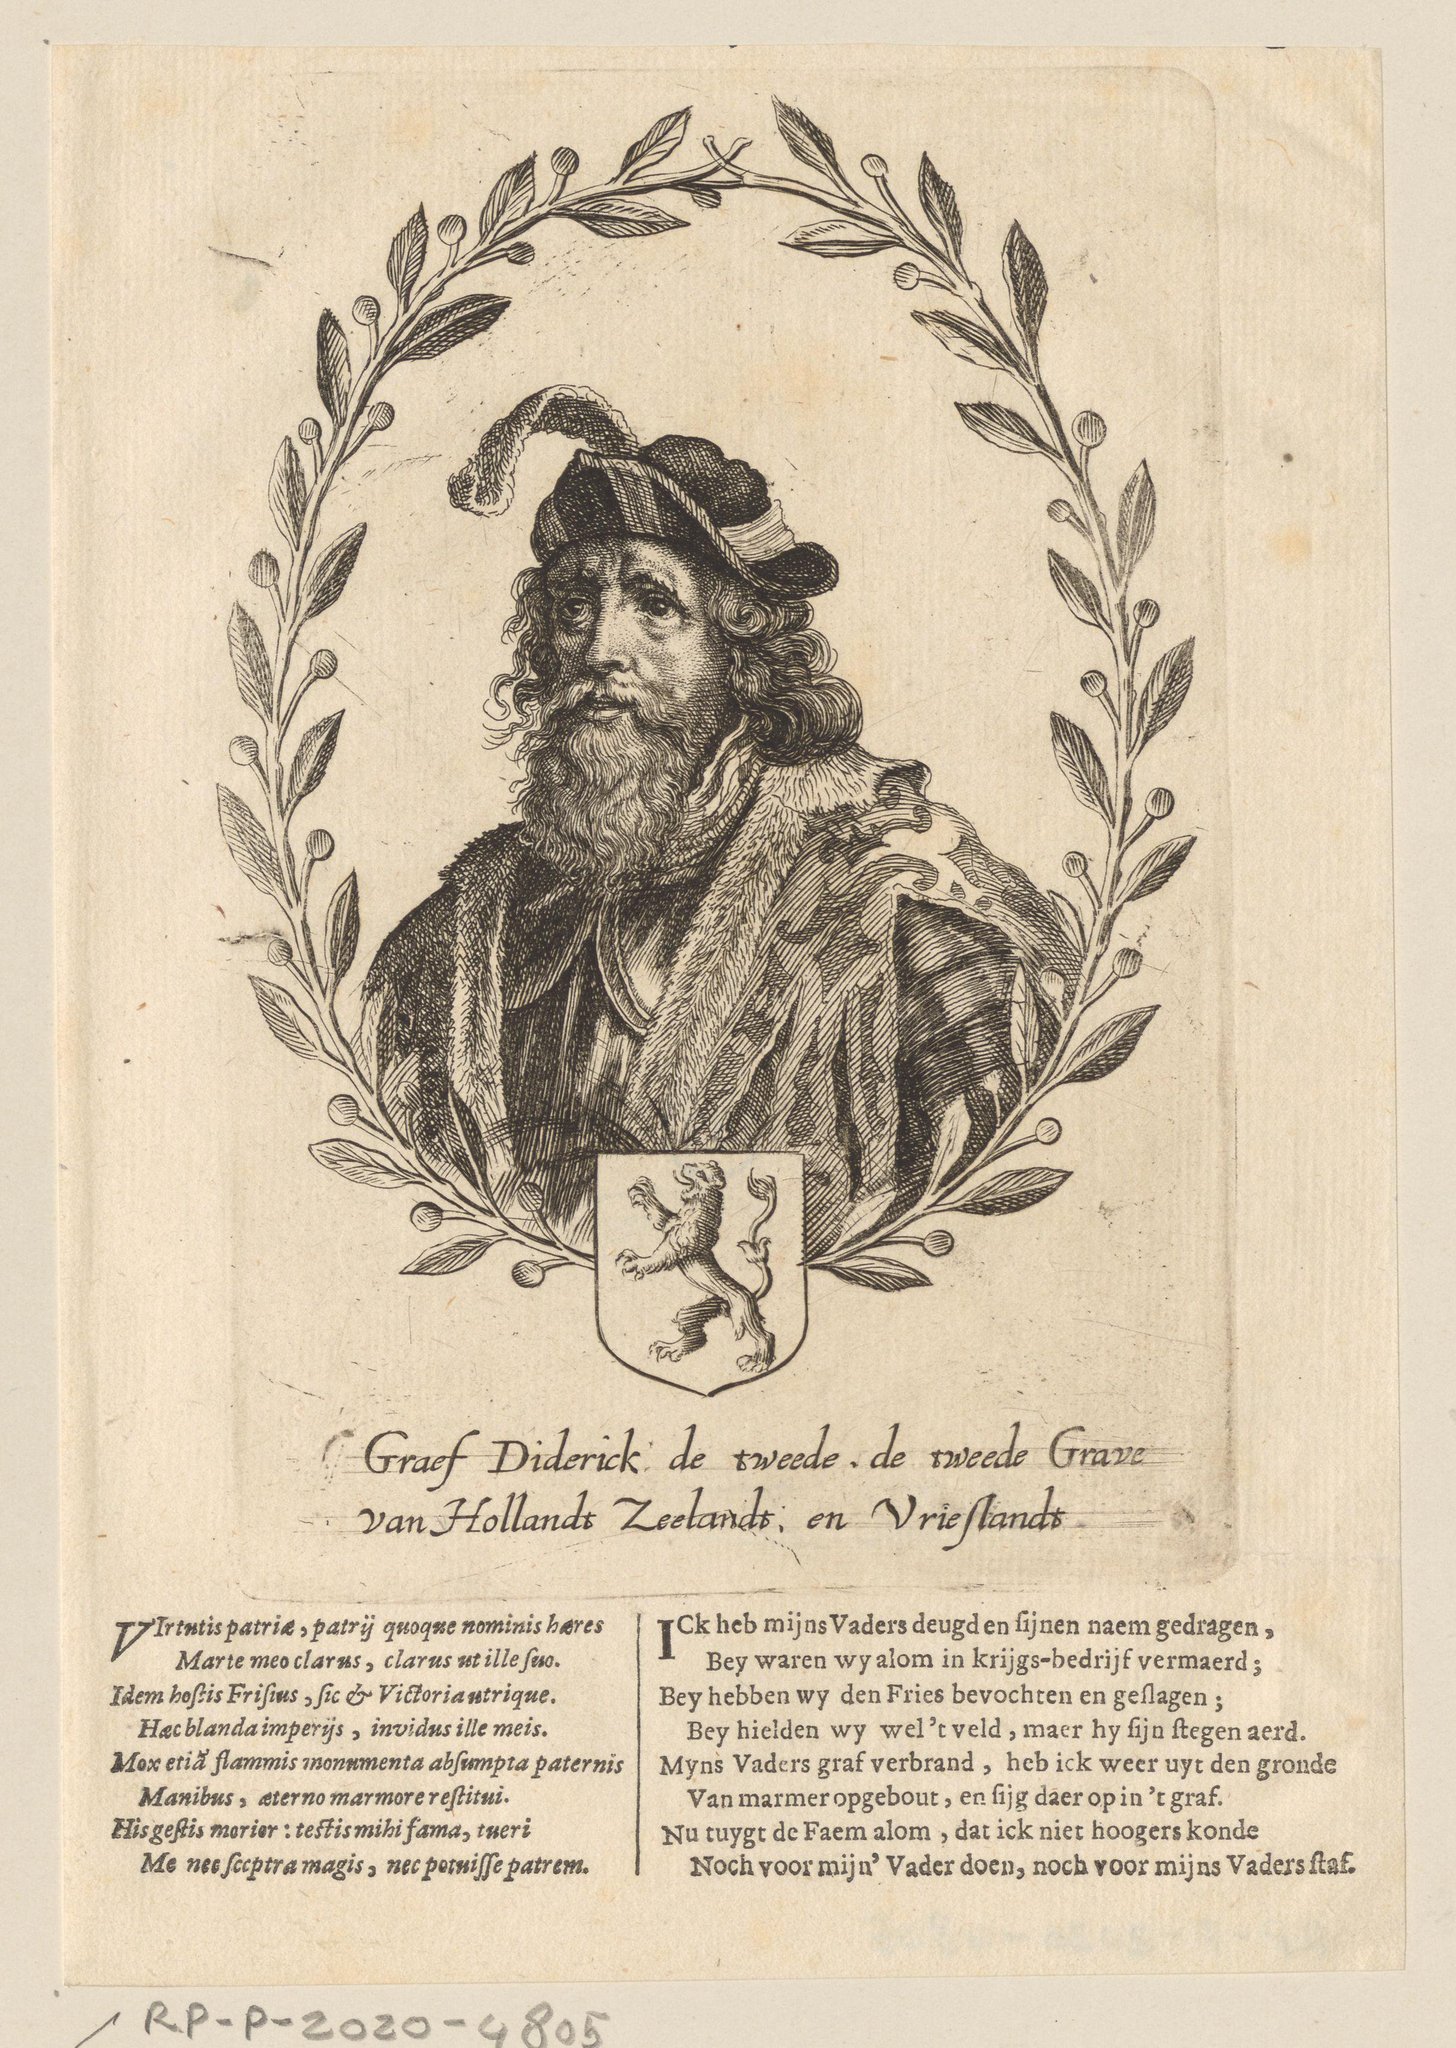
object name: book illustration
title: Portret van Dirk II, graaf van Holland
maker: Anonymous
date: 1667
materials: paper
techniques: engraving, etching, letterpress printing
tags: historical persons, head-gear: hat, ruler, sovereign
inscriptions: collector's mark: Lugt 964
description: Prent mogelijk uit: Scriverius, Petrus. Oude en nieuwe beschryvinge van Holland, Zeeland en Vriesland (...). Den Haag: Levijn van Dijck, 1667. Of uit: Scriverius, Petrus. Hollandsche, Zeelandsche ende Vriesche chronyck. Den Haag: Johannes Tongerloo en Levijn van Dijck, s.a.